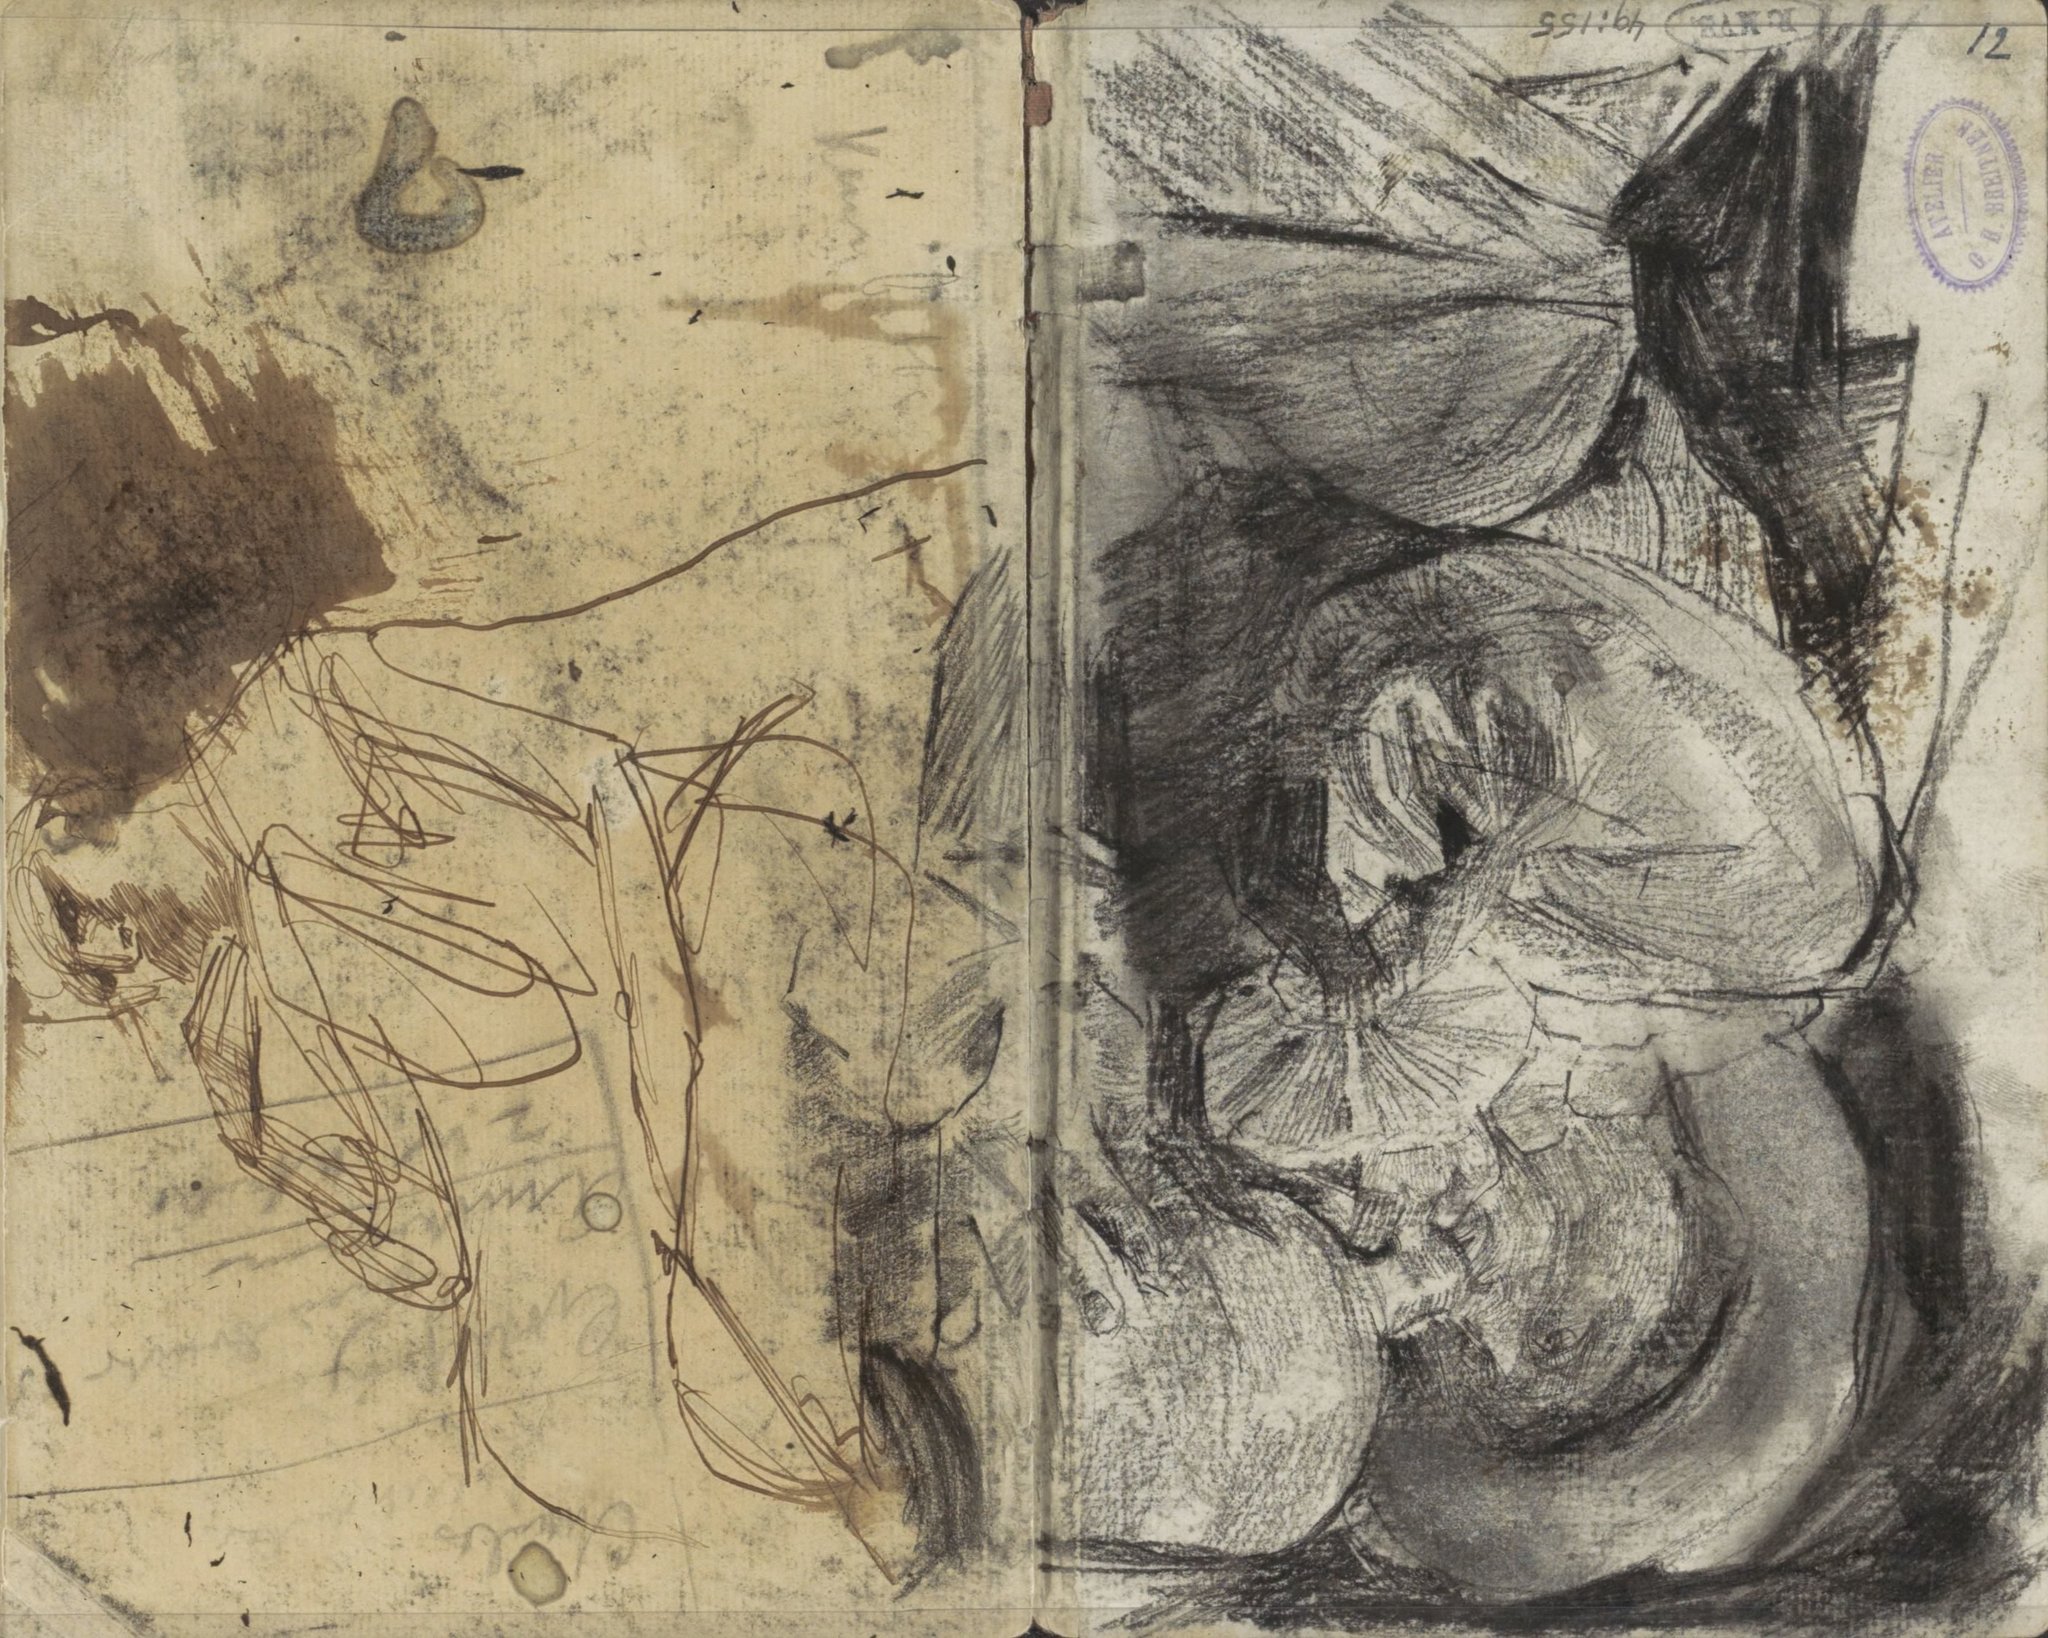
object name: sketchbook leaf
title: Drinkende man in zeventiende-eeuwse kleding en een zittende man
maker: george hendrik breitner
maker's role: draughtsman, painter, print maker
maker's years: 1857-1923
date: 1881-1883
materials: chalk, ink, paper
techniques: stumping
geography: the hague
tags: adult man, jar, jug (used as drinking-vessel), drinking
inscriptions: collector's mark: Lugt 2228, workshop stamp: Lugt 291d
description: Blad 11 verso en blad 12, achterste schutblad, uit een schetsboek met 9 bladen.